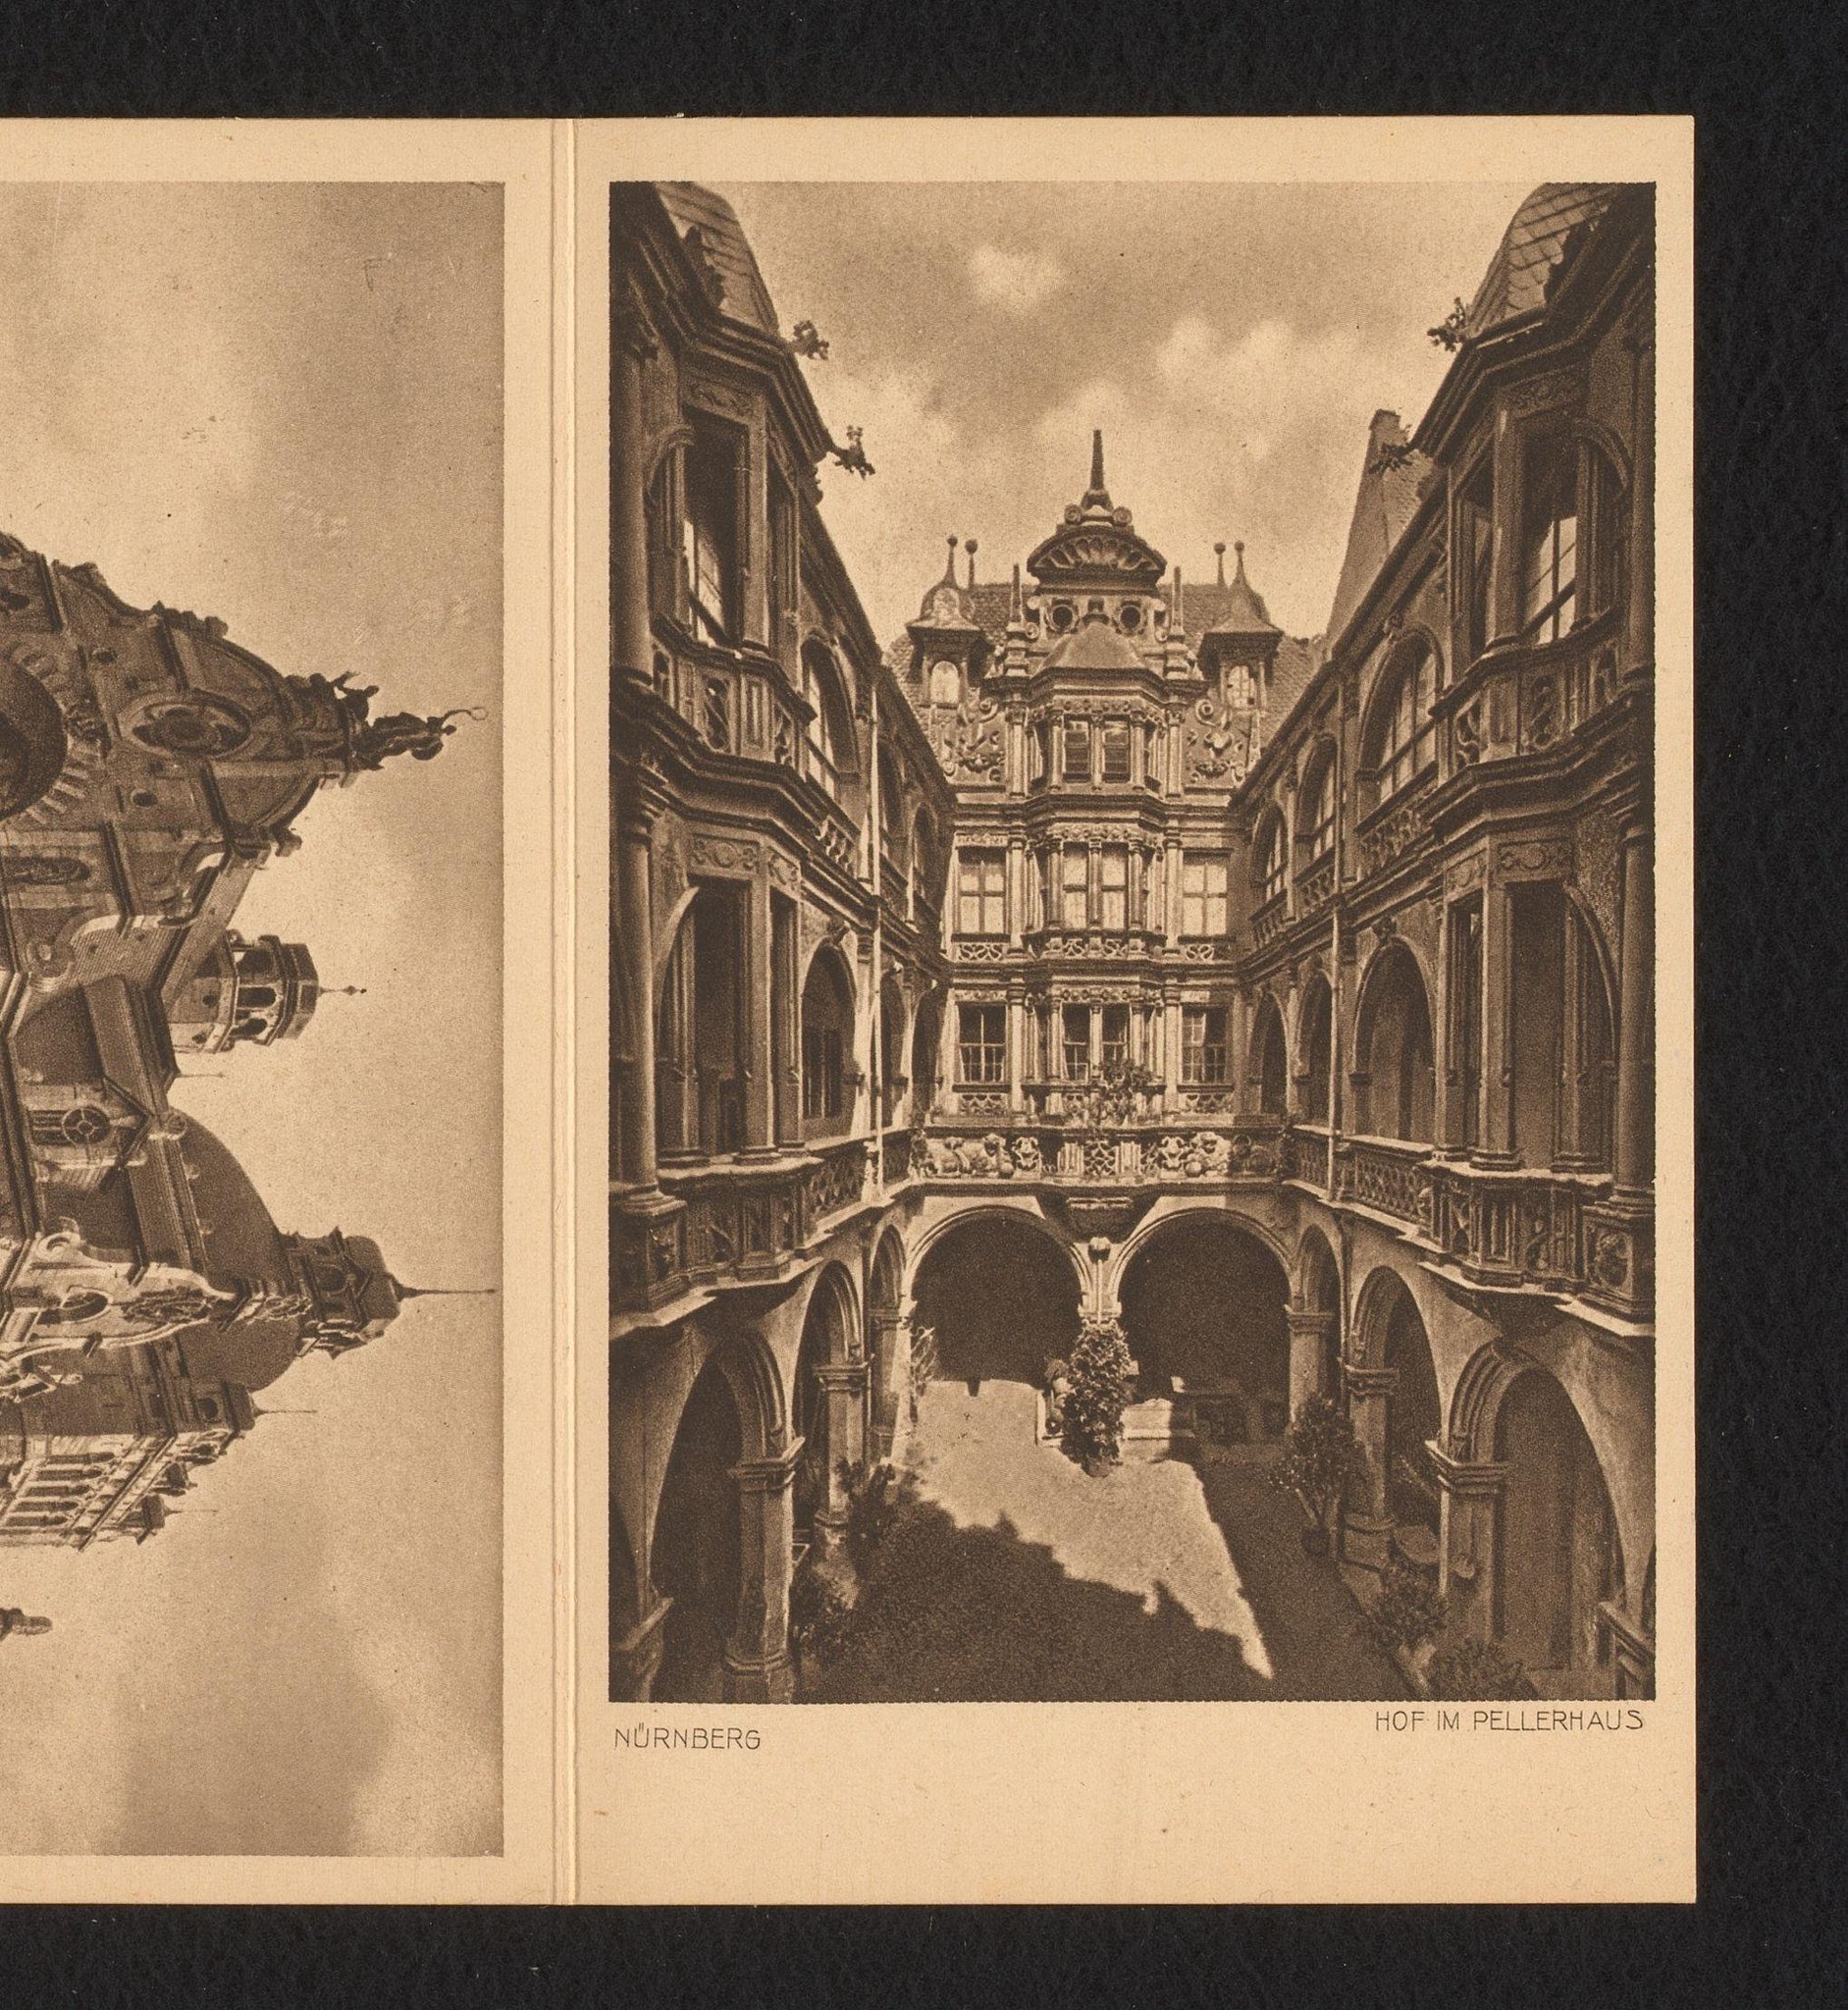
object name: photomechanical print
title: Nürnberg. Hof im Pellerhaus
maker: Anonymous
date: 1905-1930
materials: cardboard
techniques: rotogravure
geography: nuremberg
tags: archive, public library